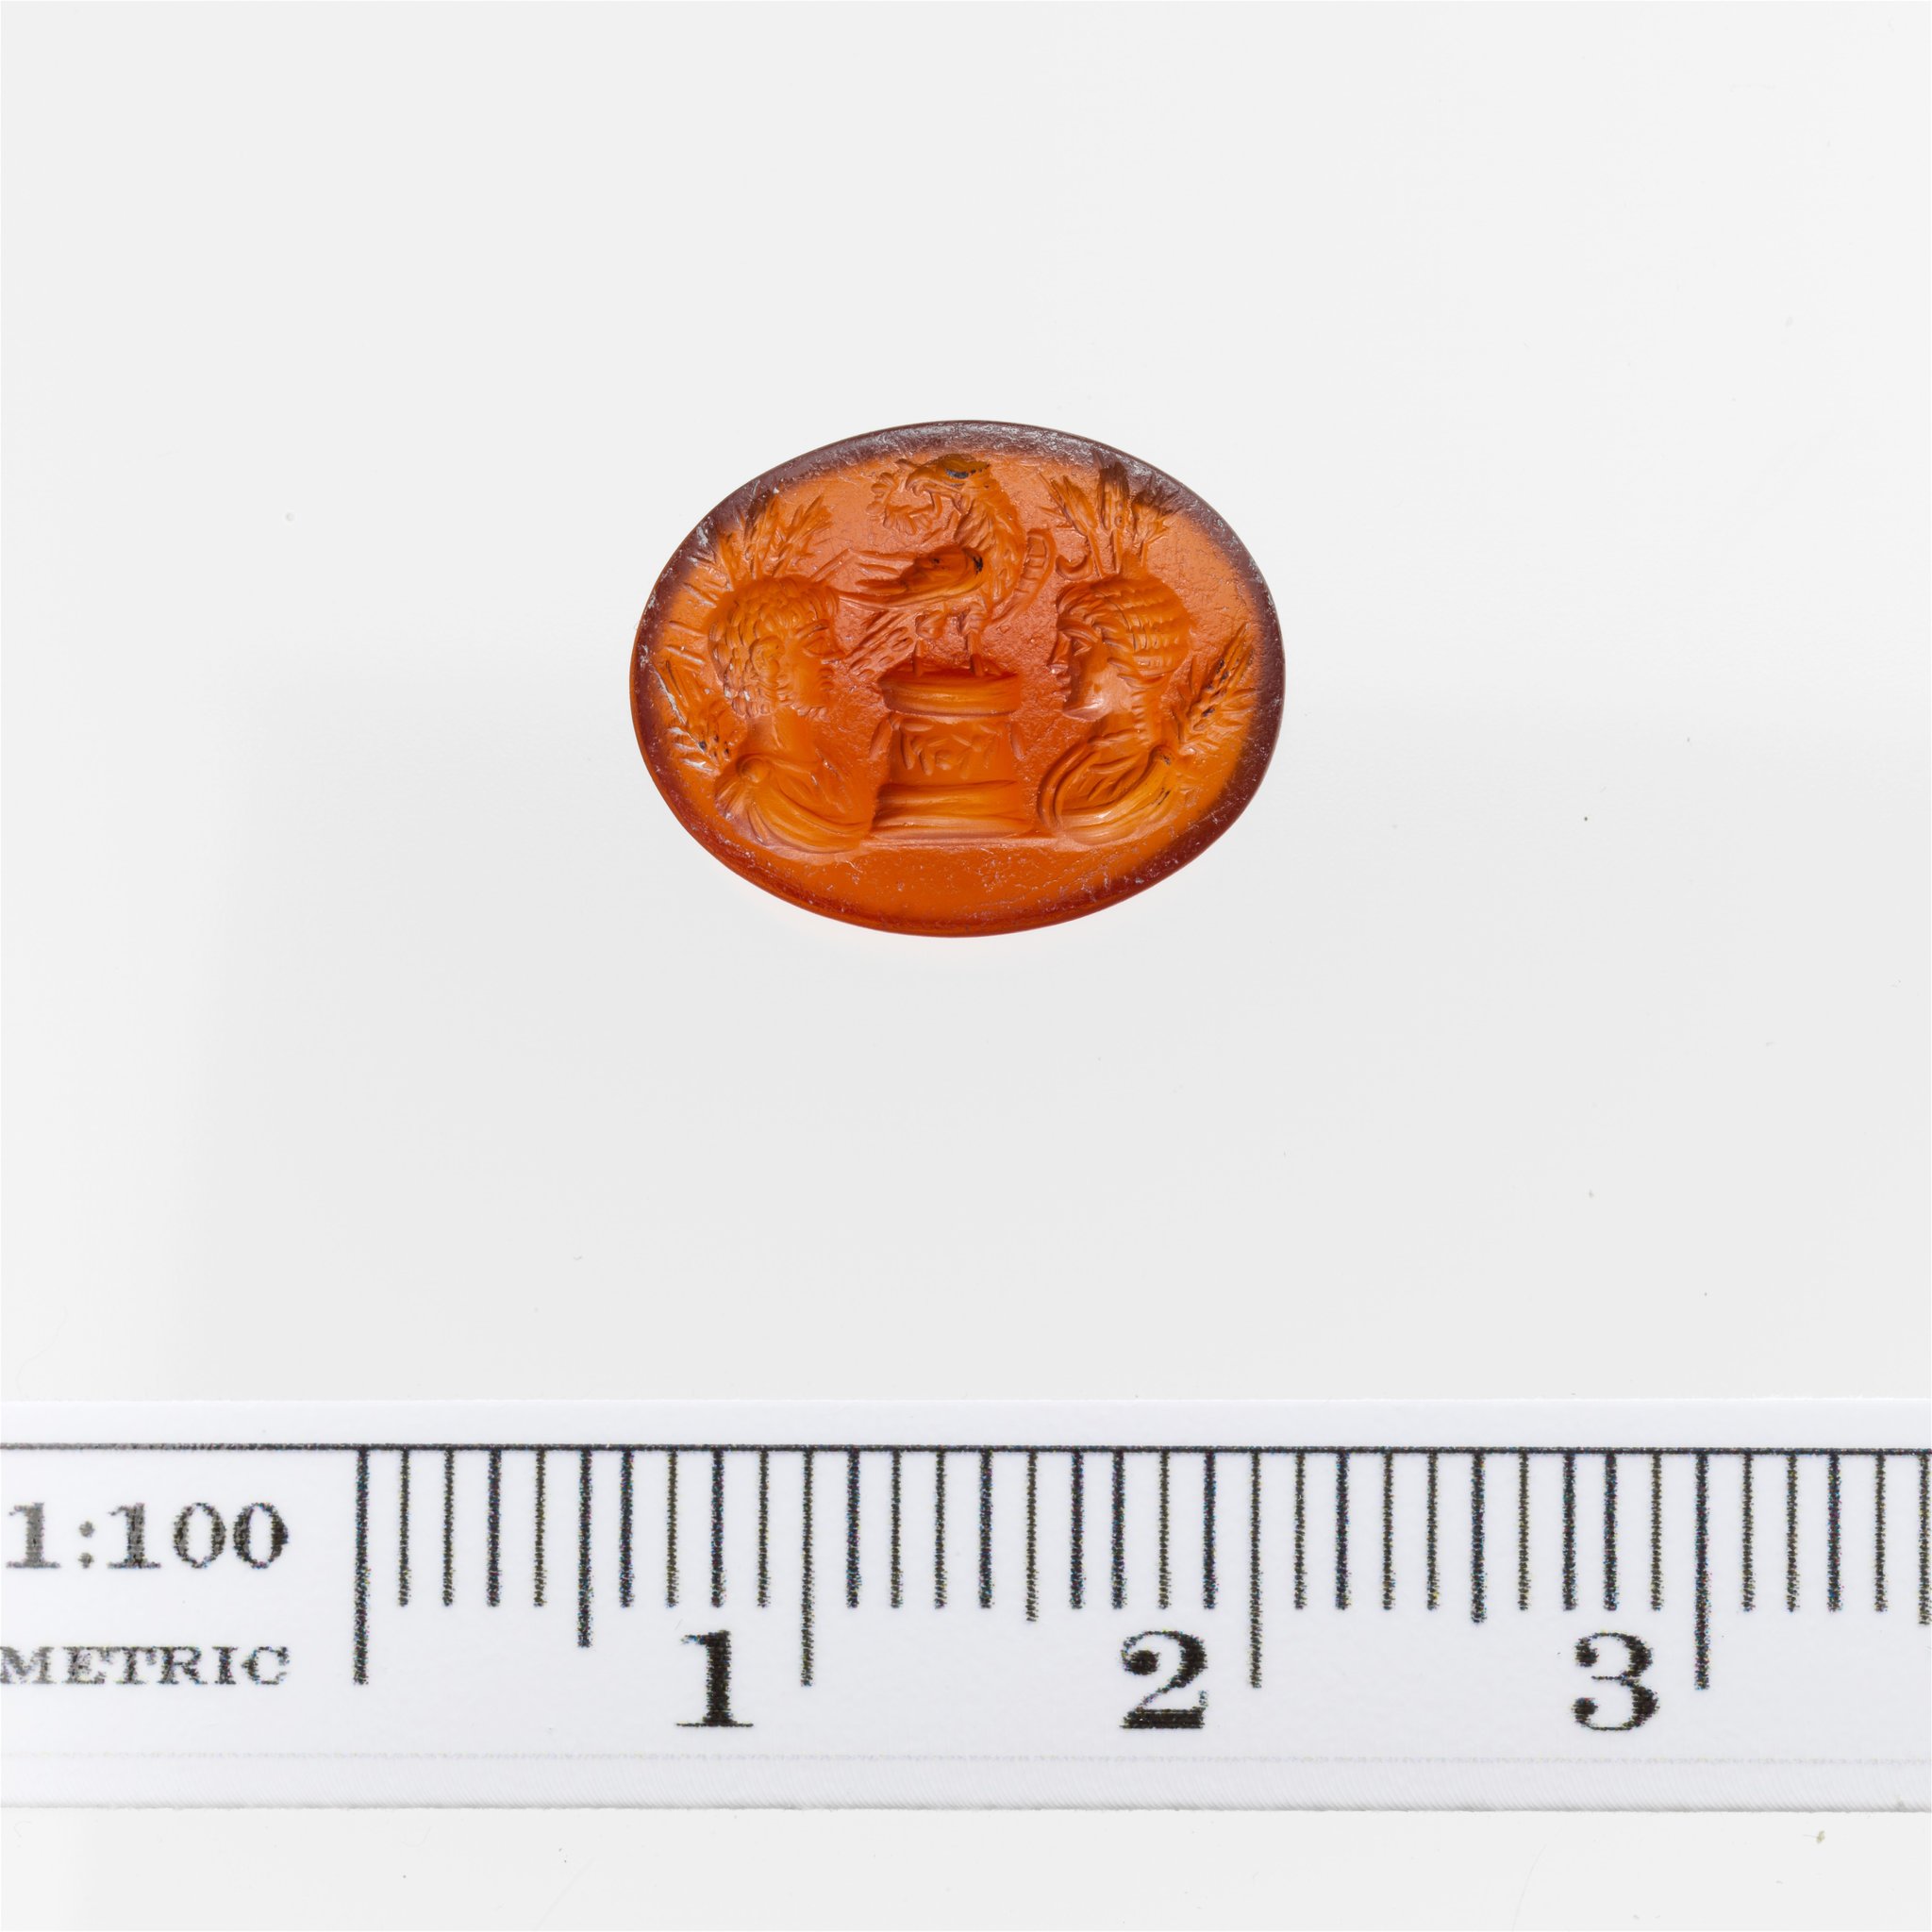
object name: intaglio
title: Carnelian ring stone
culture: roman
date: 177-192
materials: gemstone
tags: eagles,altars,men,women